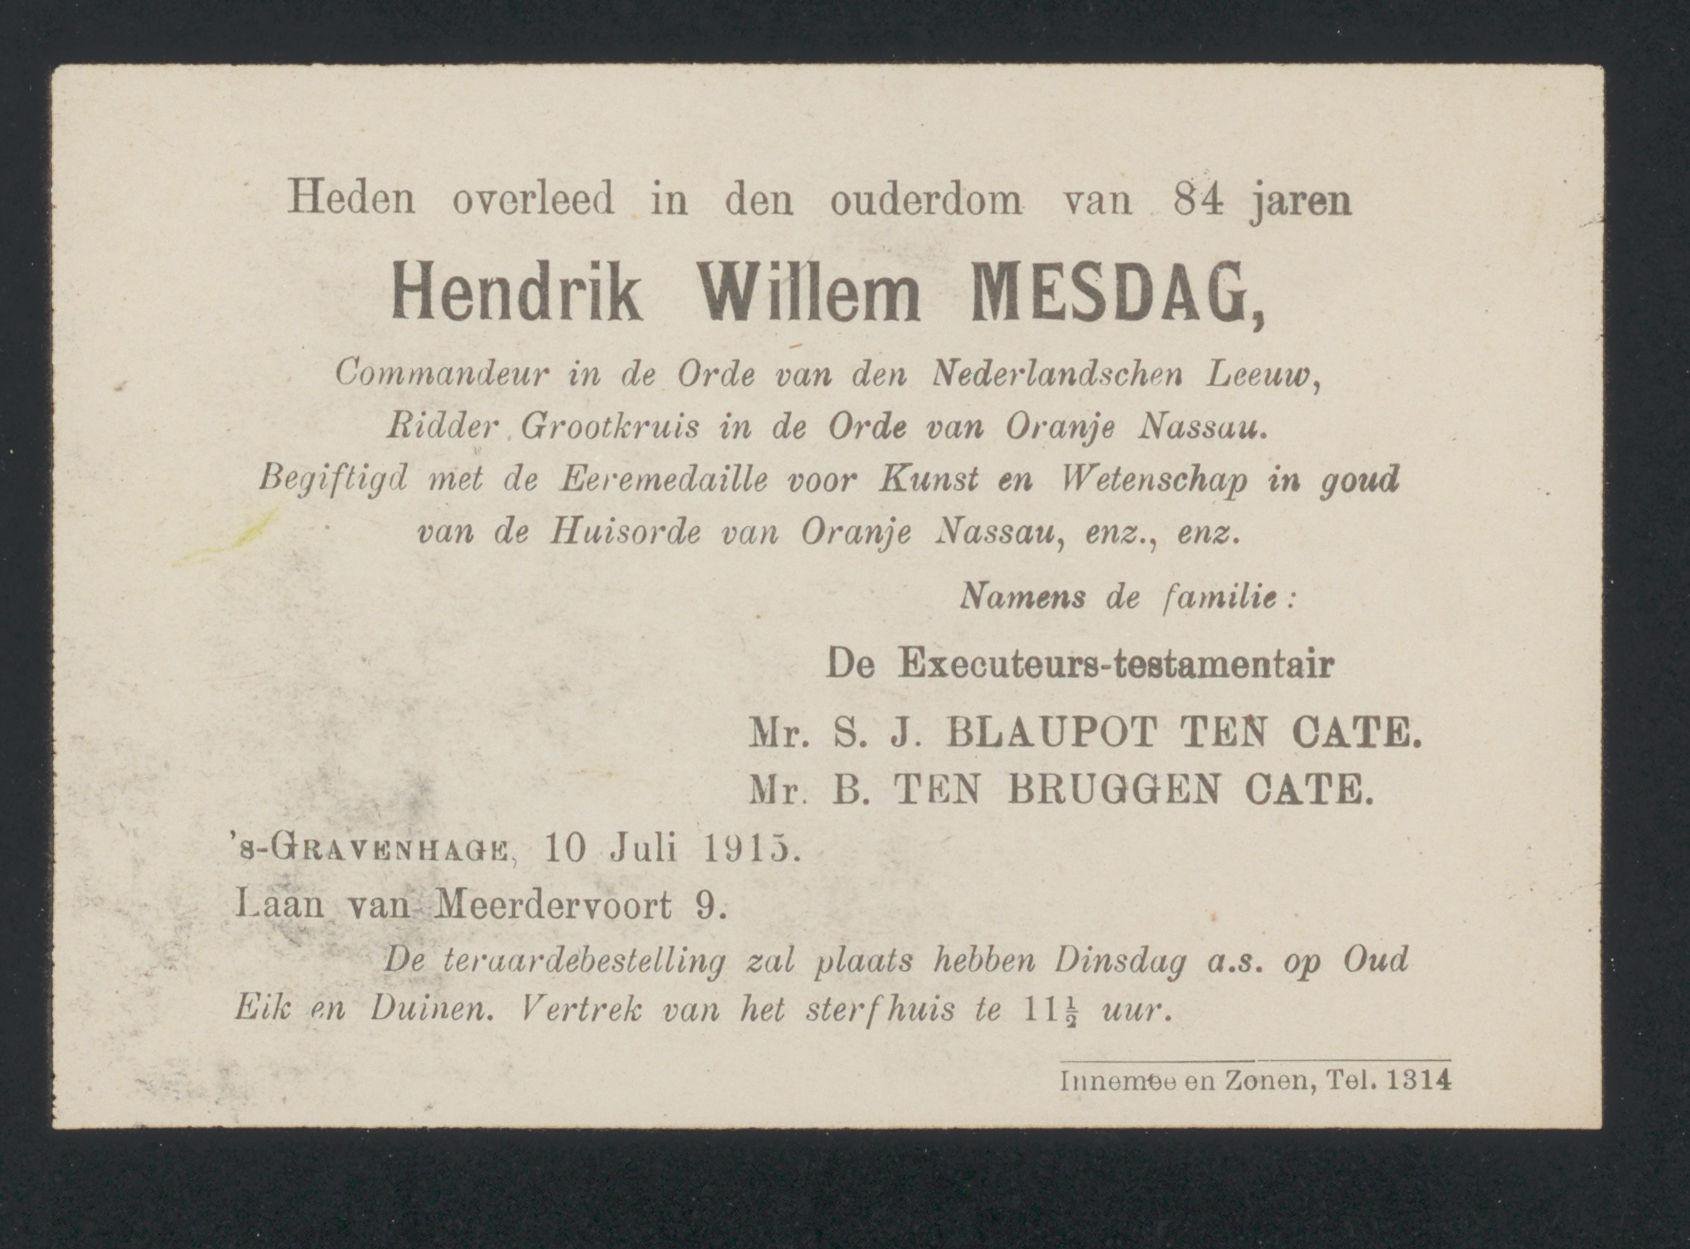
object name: overlijdensbericht, overlijdensadvertentie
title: Overlijdensbericht aan Philip Zilcken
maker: Anonymous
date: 1915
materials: cardboard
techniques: printing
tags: hendrik willem mesdag, the hague, painter, draughtsman, philip zilcken